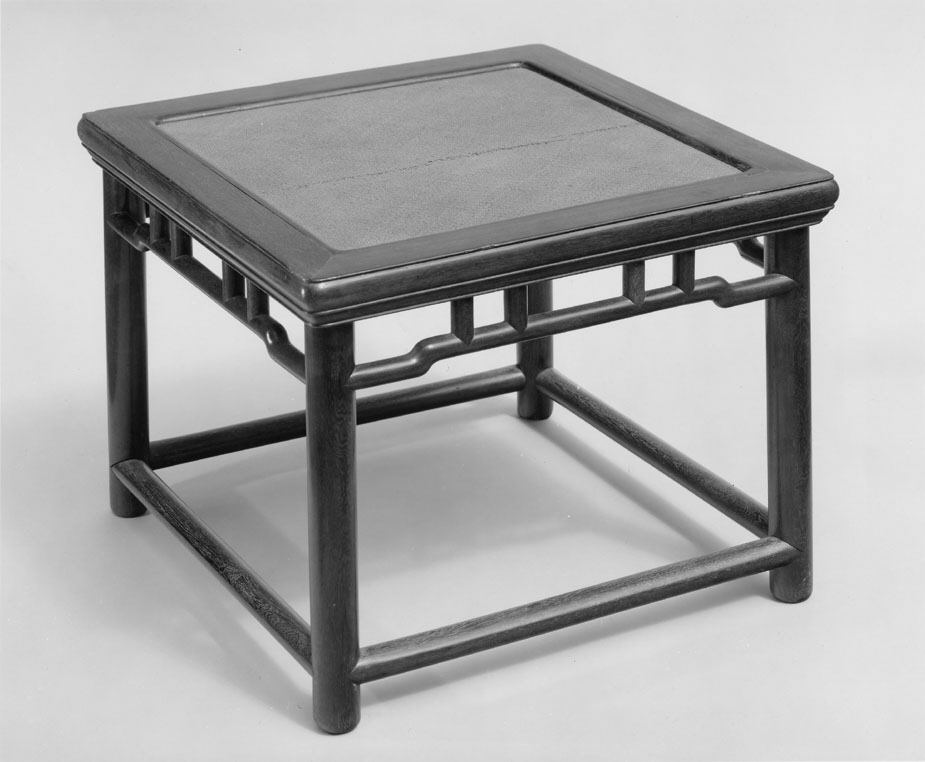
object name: stool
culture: chinese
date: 1601-1800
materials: wood